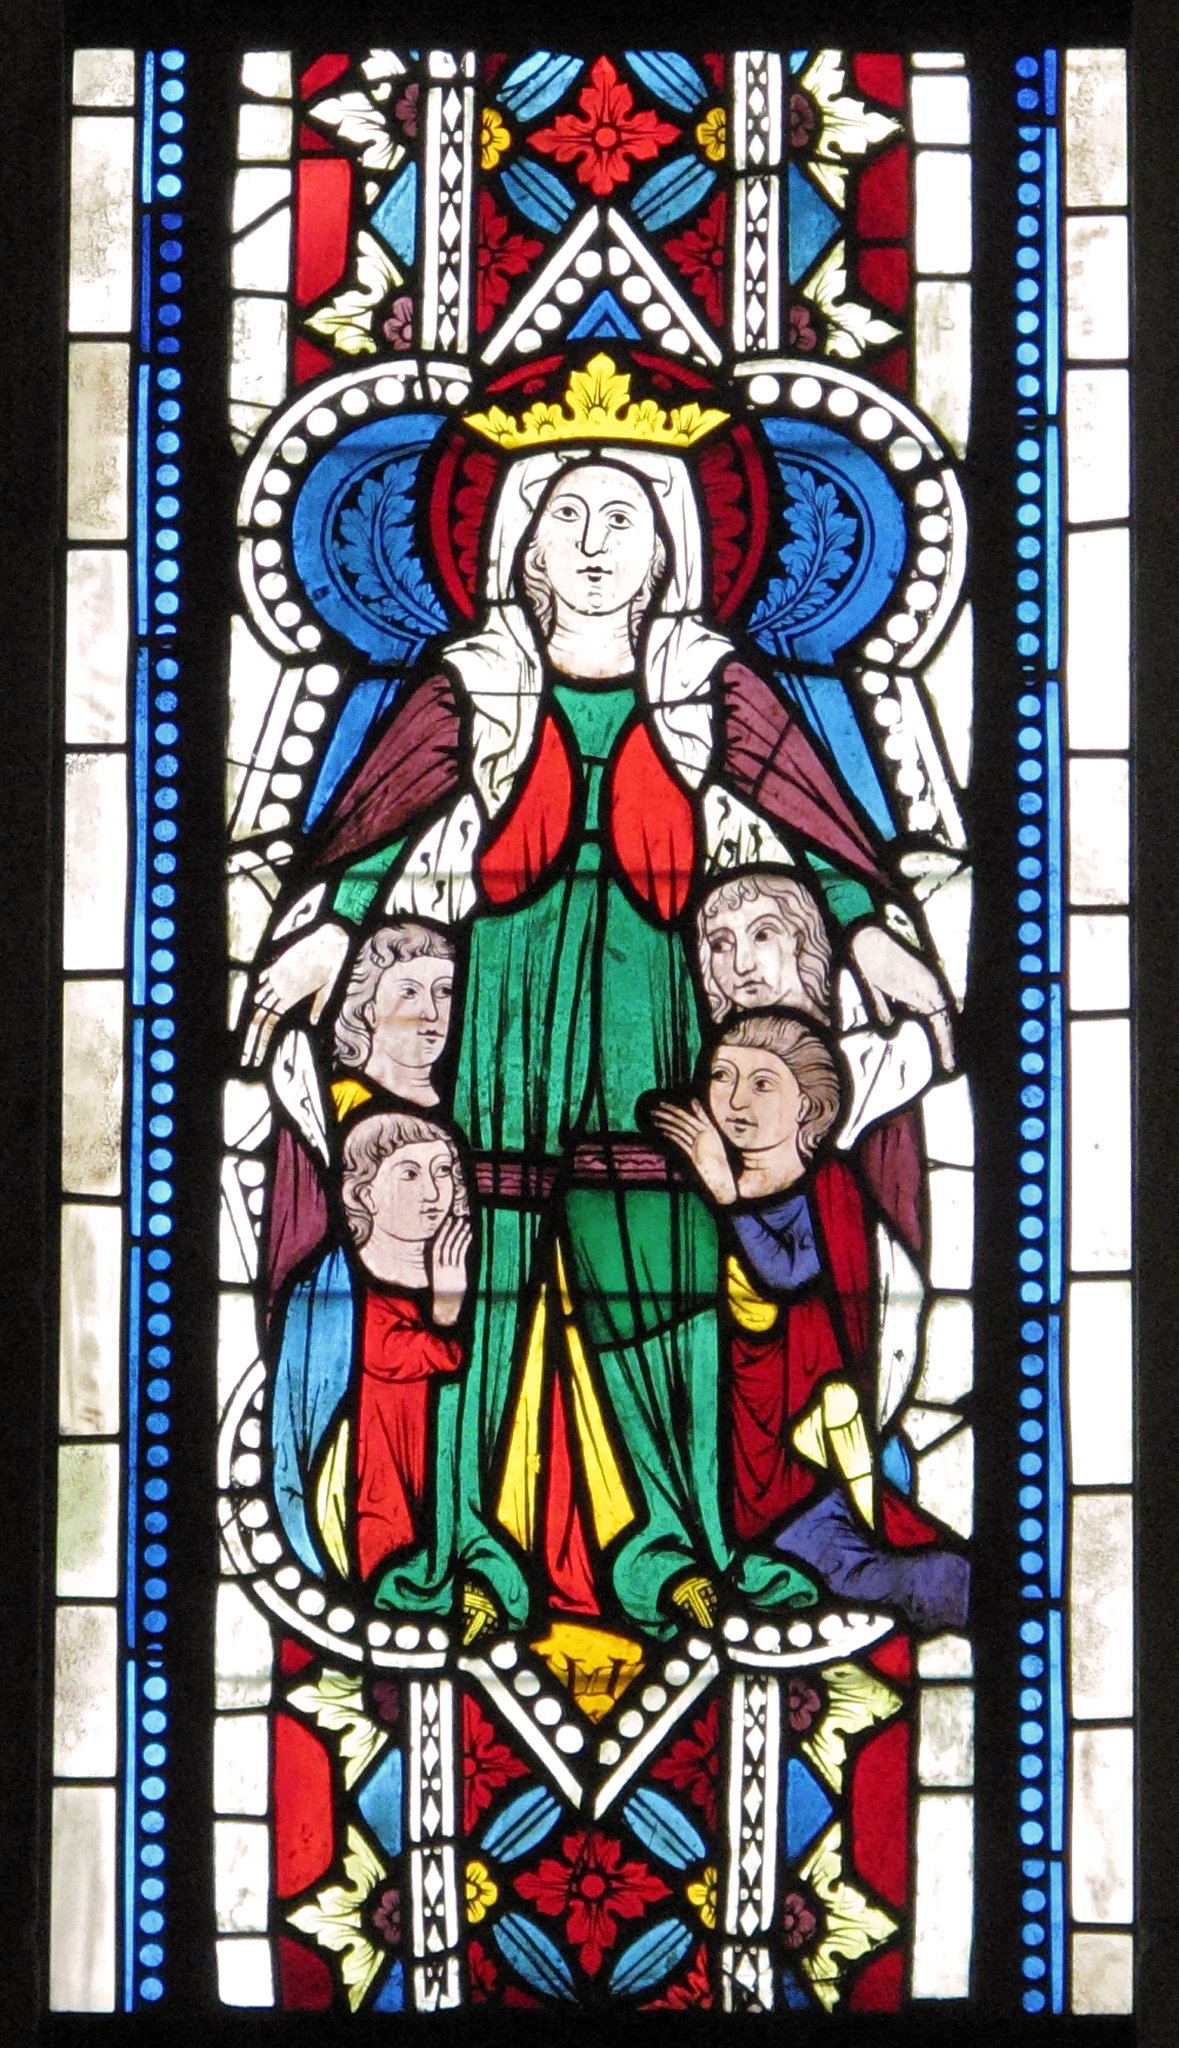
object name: panel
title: Madonna of Mercy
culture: austrian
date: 1340-1350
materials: glass, metal, paint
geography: austria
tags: virgin mary